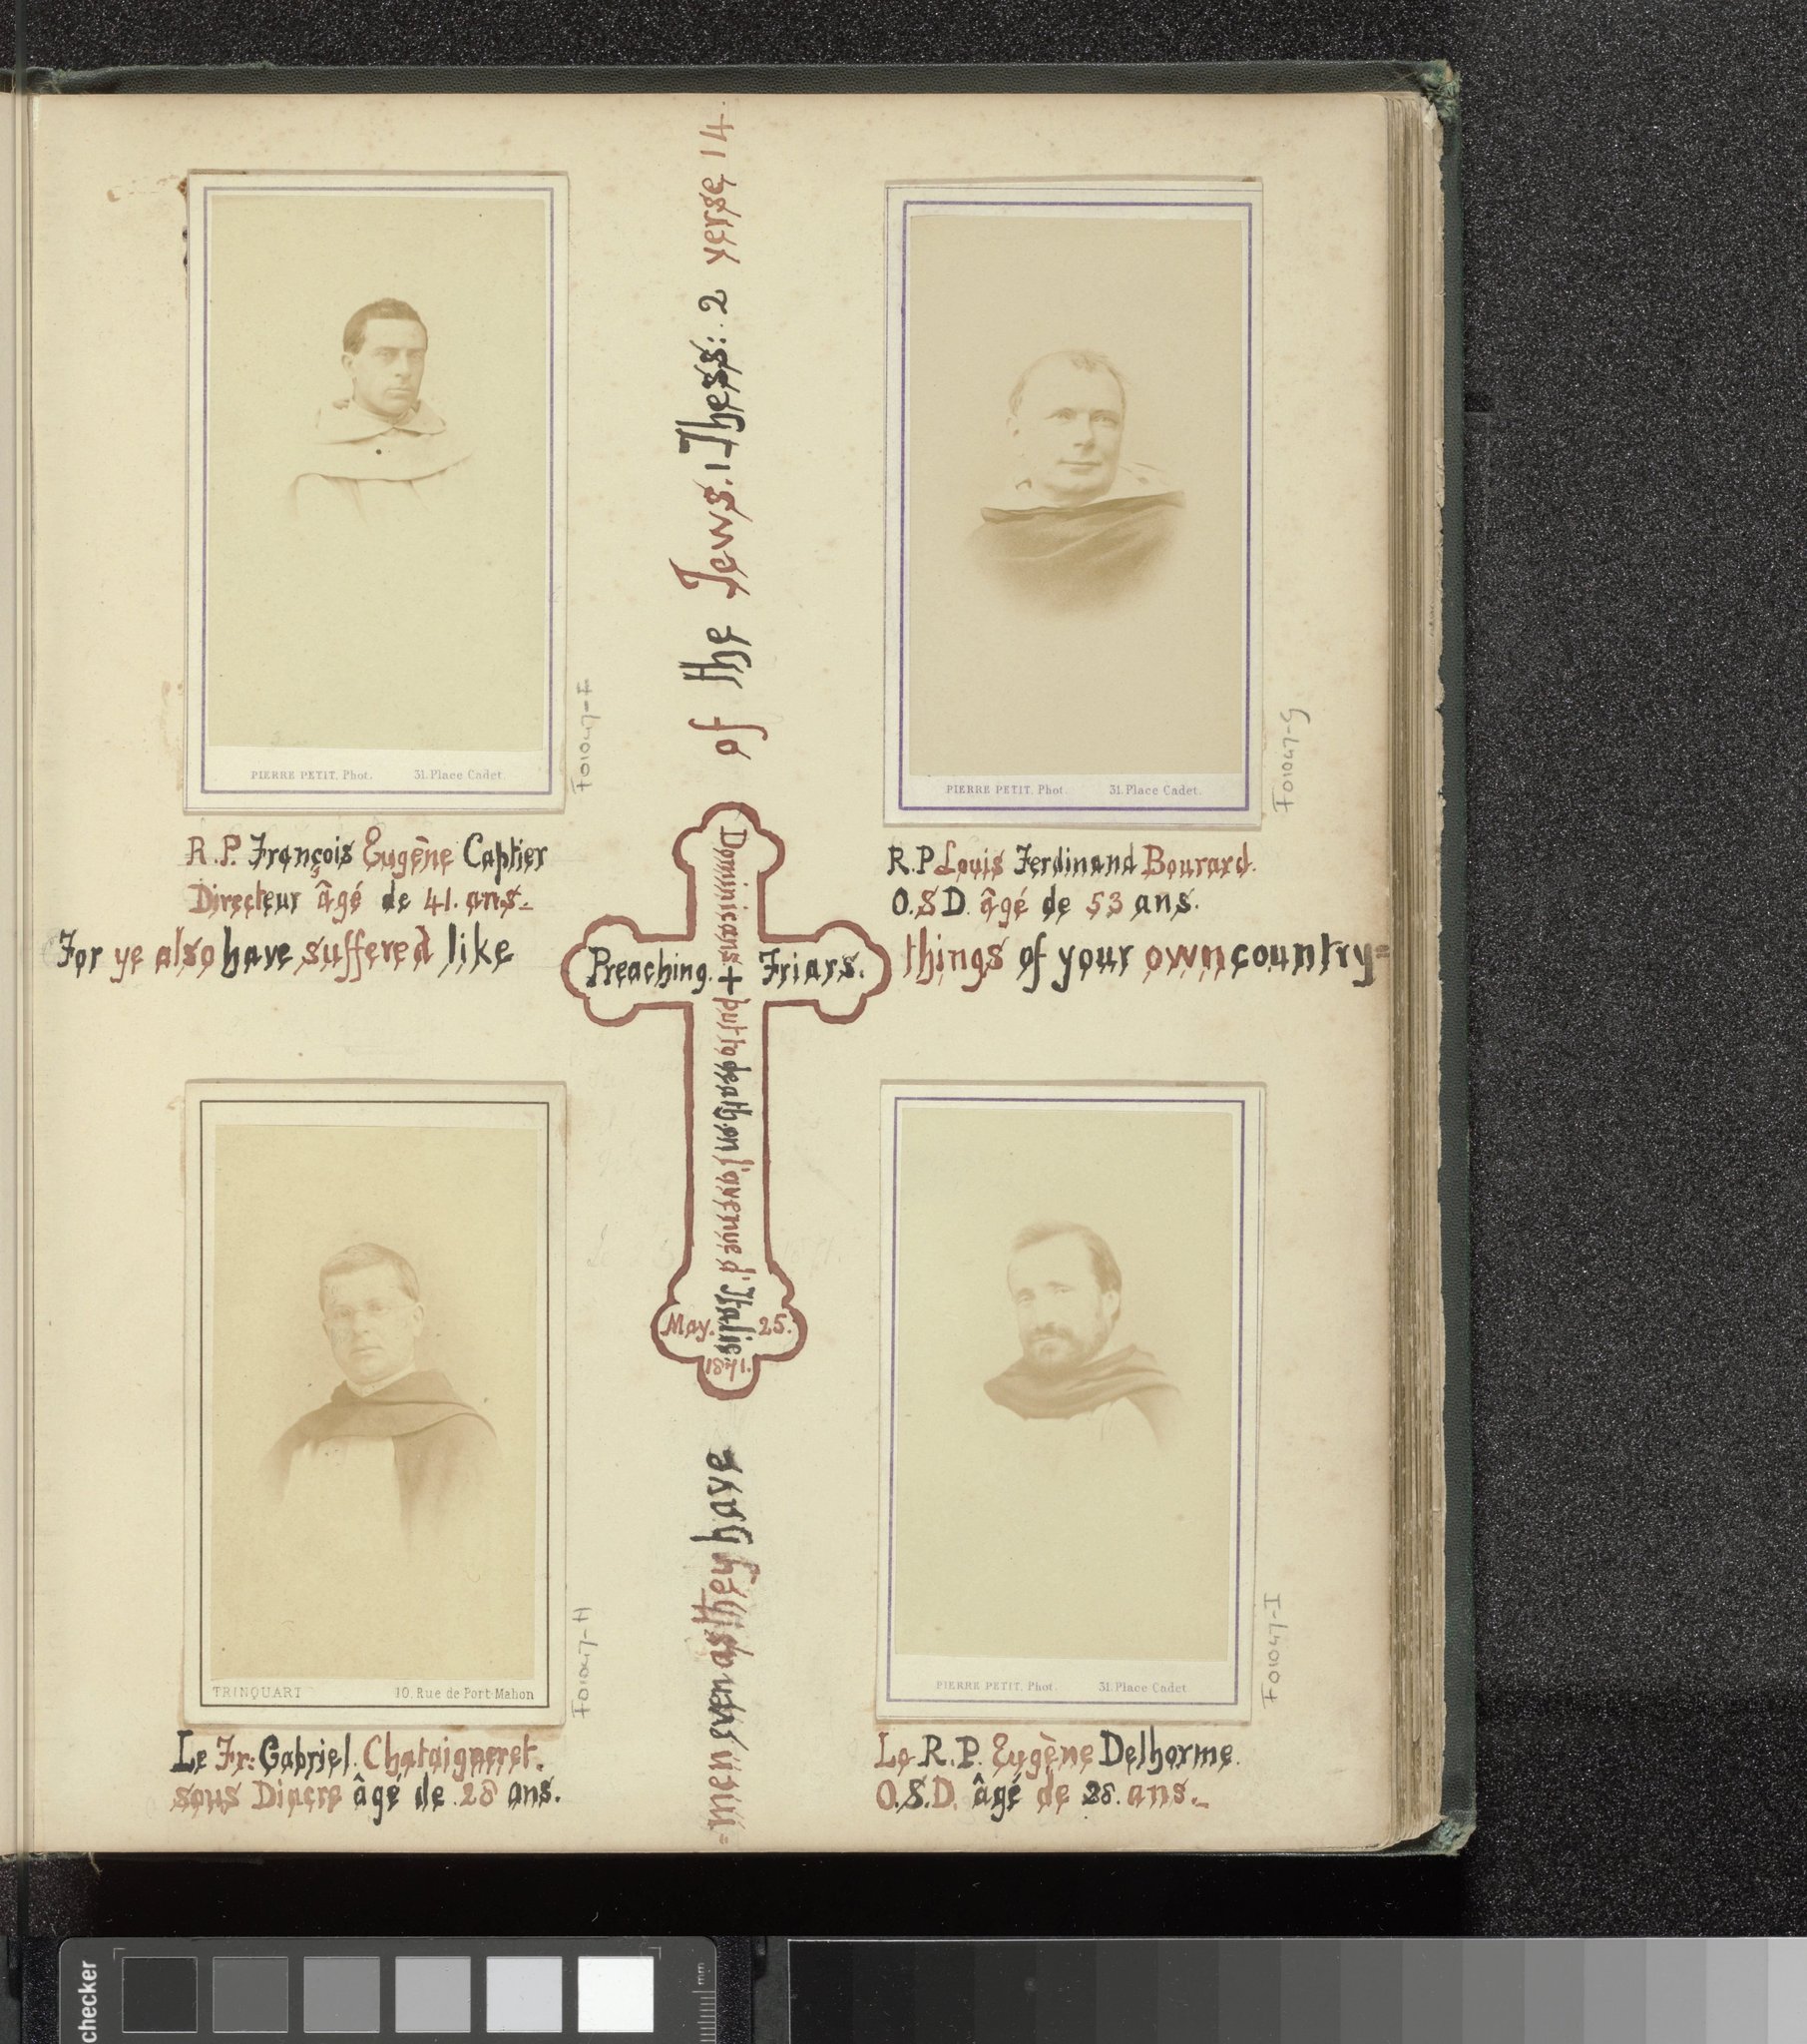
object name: photograph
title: Portret van R.P. François Eugène Captier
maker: pierre petit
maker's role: fotograaf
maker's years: 1832-1909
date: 1871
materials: cardboard, paper, photographic support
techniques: albumen print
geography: paris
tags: monk(s), friar(s), paris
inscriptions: address: ‘31, Place Cadet’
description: Onderdeel van Herdenkingsalbum van rooms-katholieke geestelijken gevallen tijdens de Commune van Parijs.